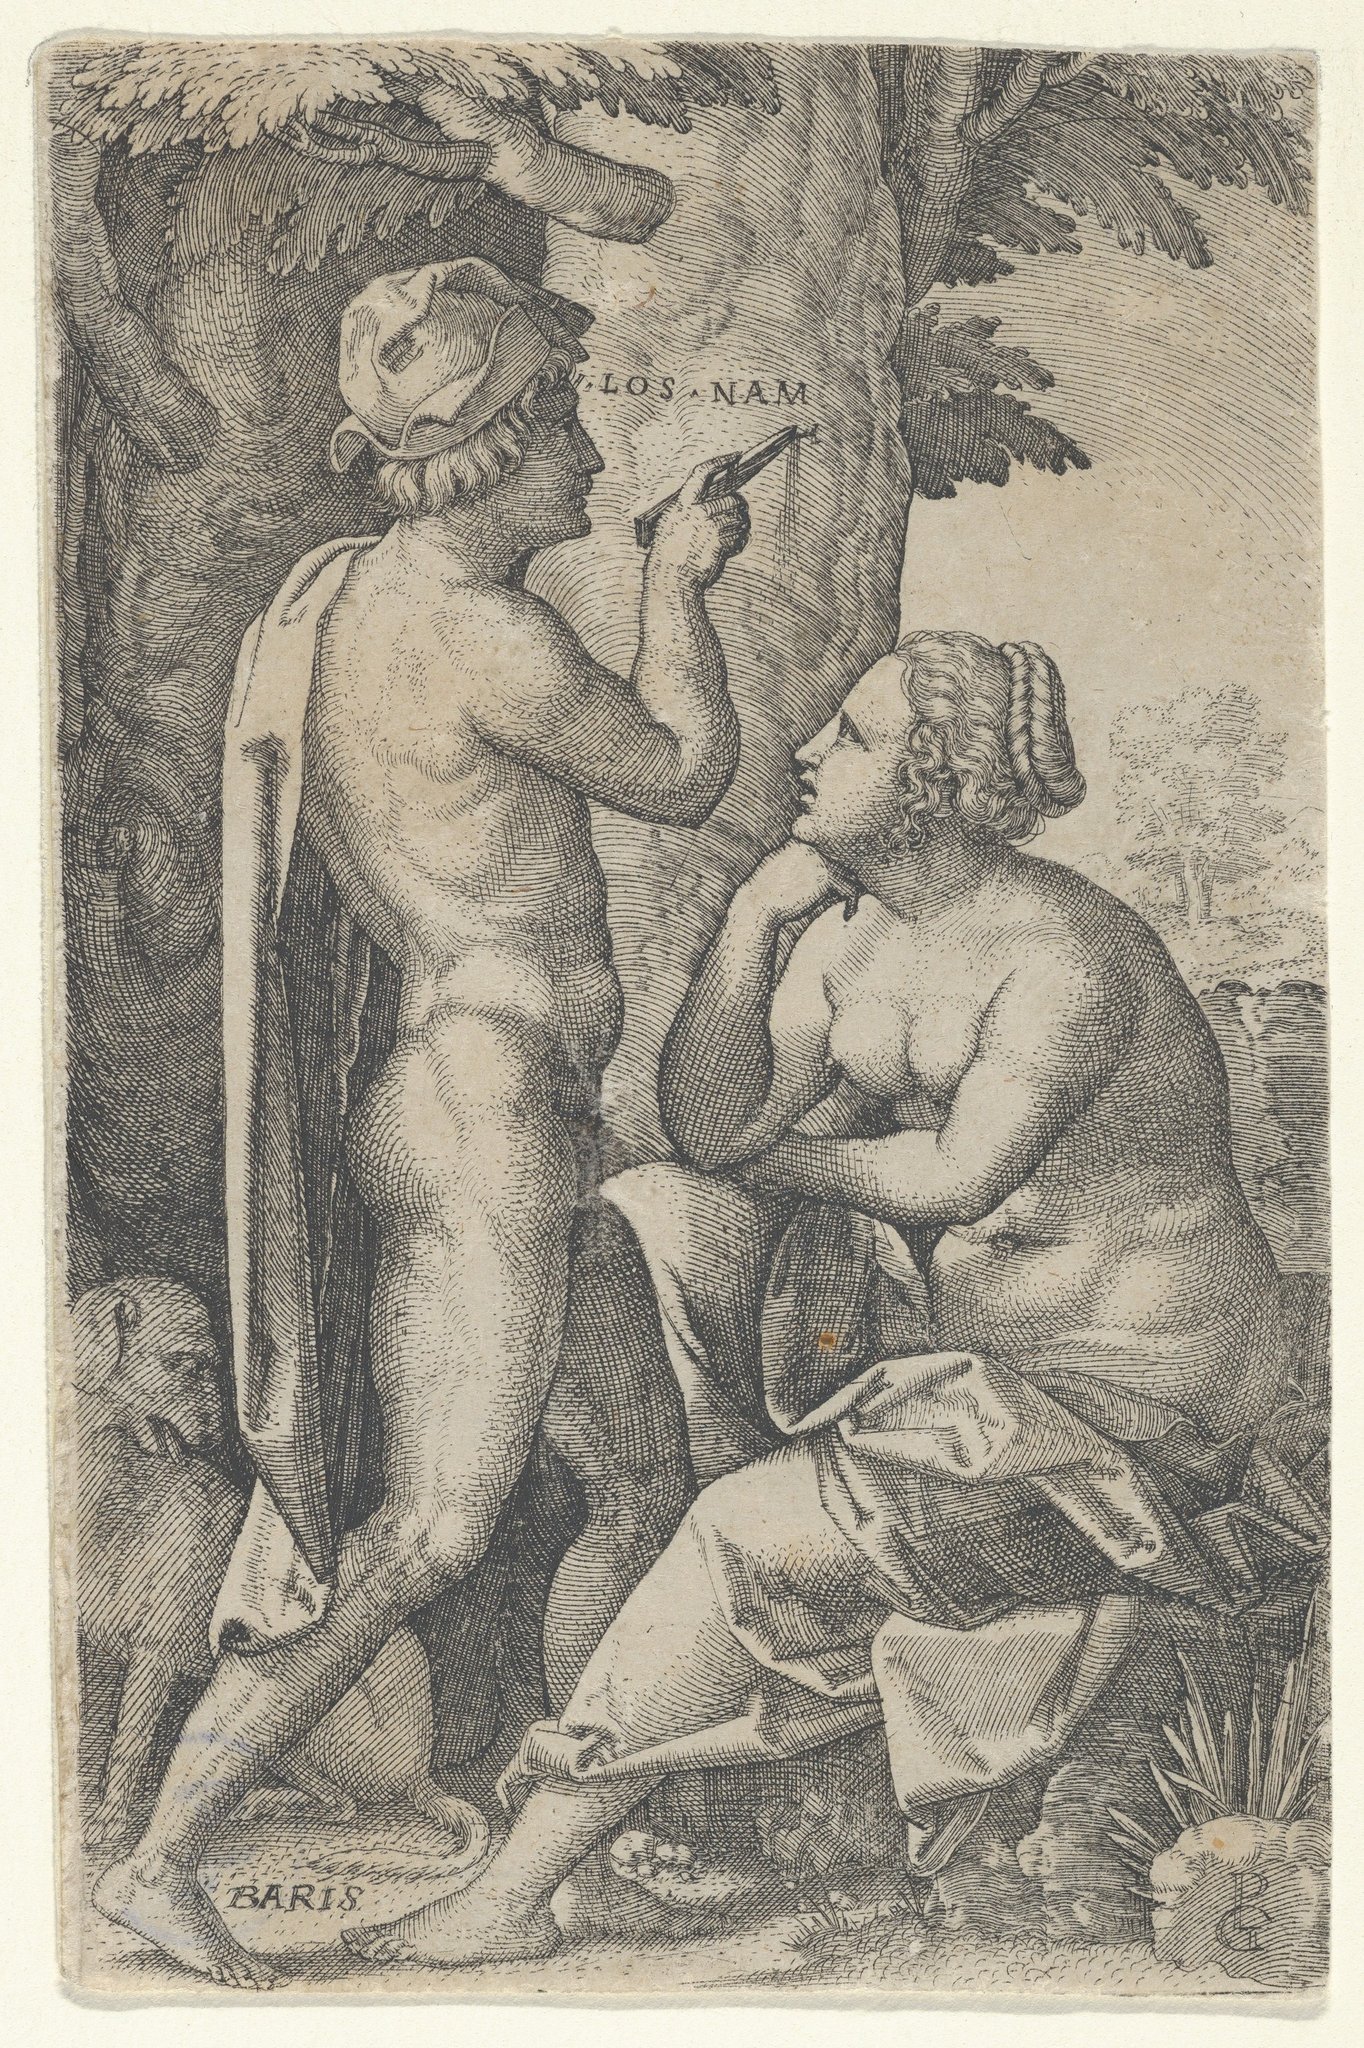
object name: print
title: Paris and Oenone, from "The Greek Heroines"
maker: georg pencz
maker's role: artist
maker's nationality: german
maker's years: 1500-1550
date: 1539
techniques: engraving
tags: male nudes,female nudes,nymphs,dogs,paris